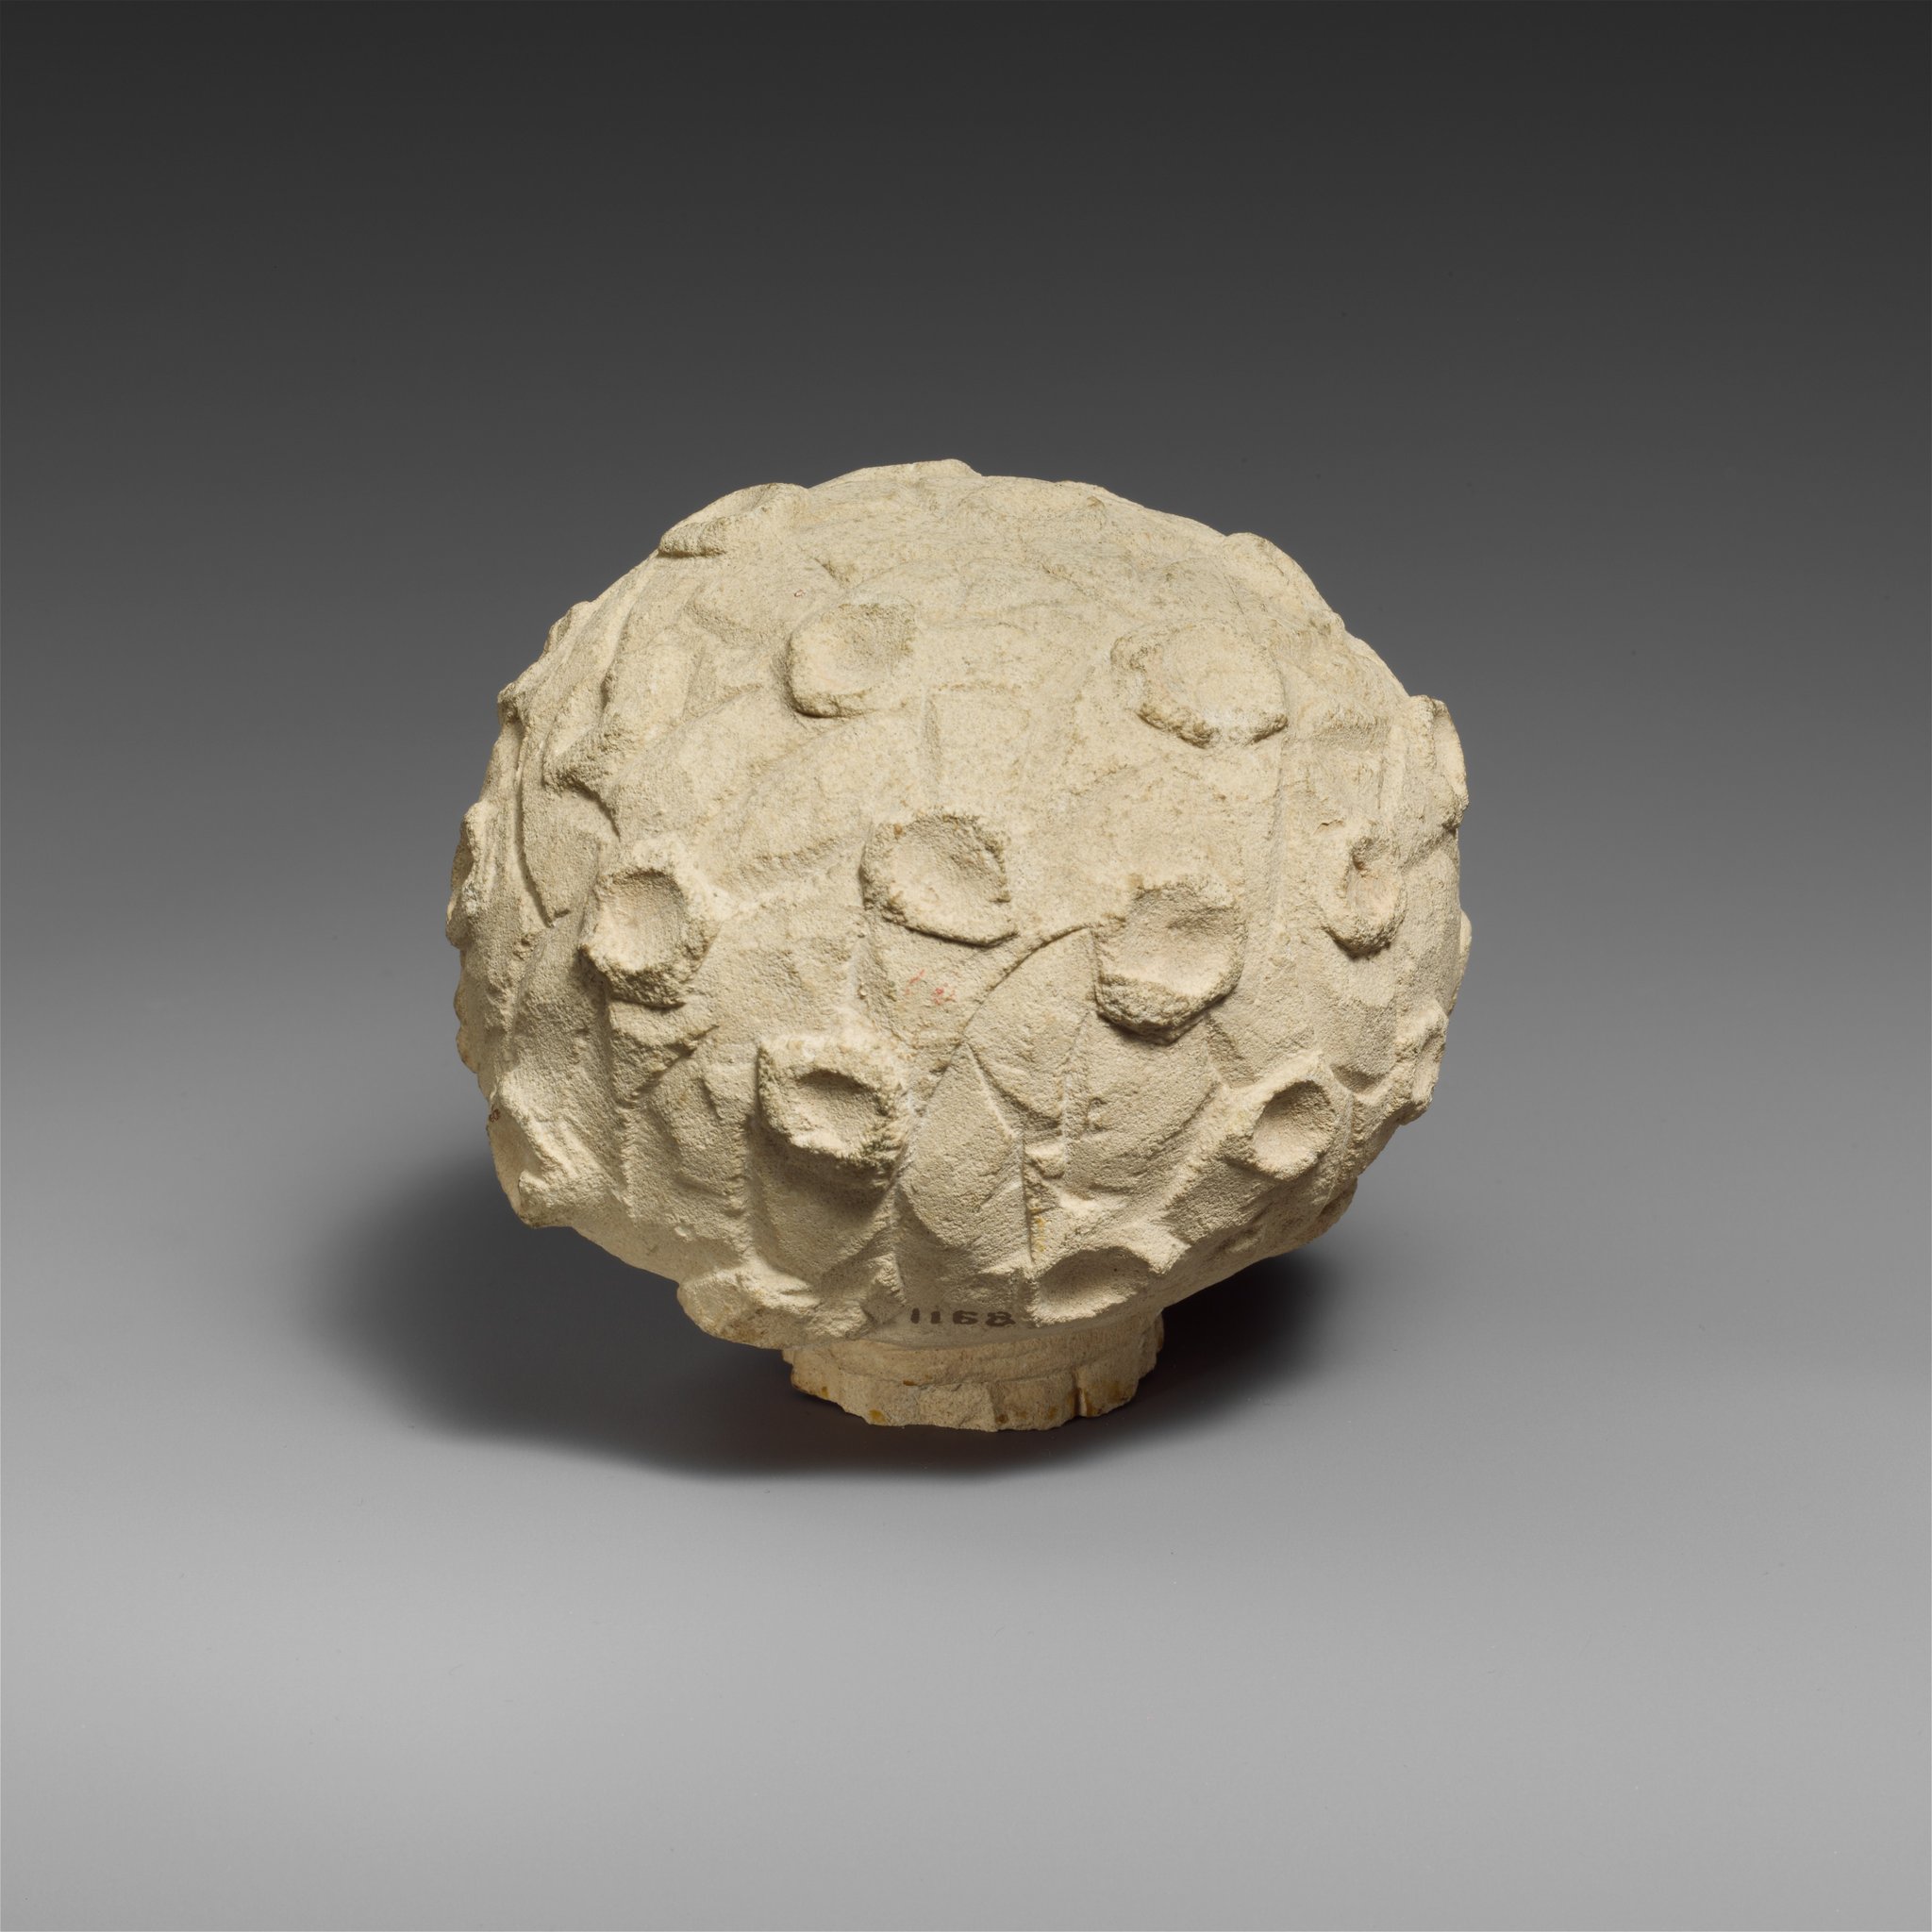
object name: fragment, floral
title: Limestone bunch of narcissus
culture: cypriot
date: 500-401 BCE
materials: limestone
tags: narcissus